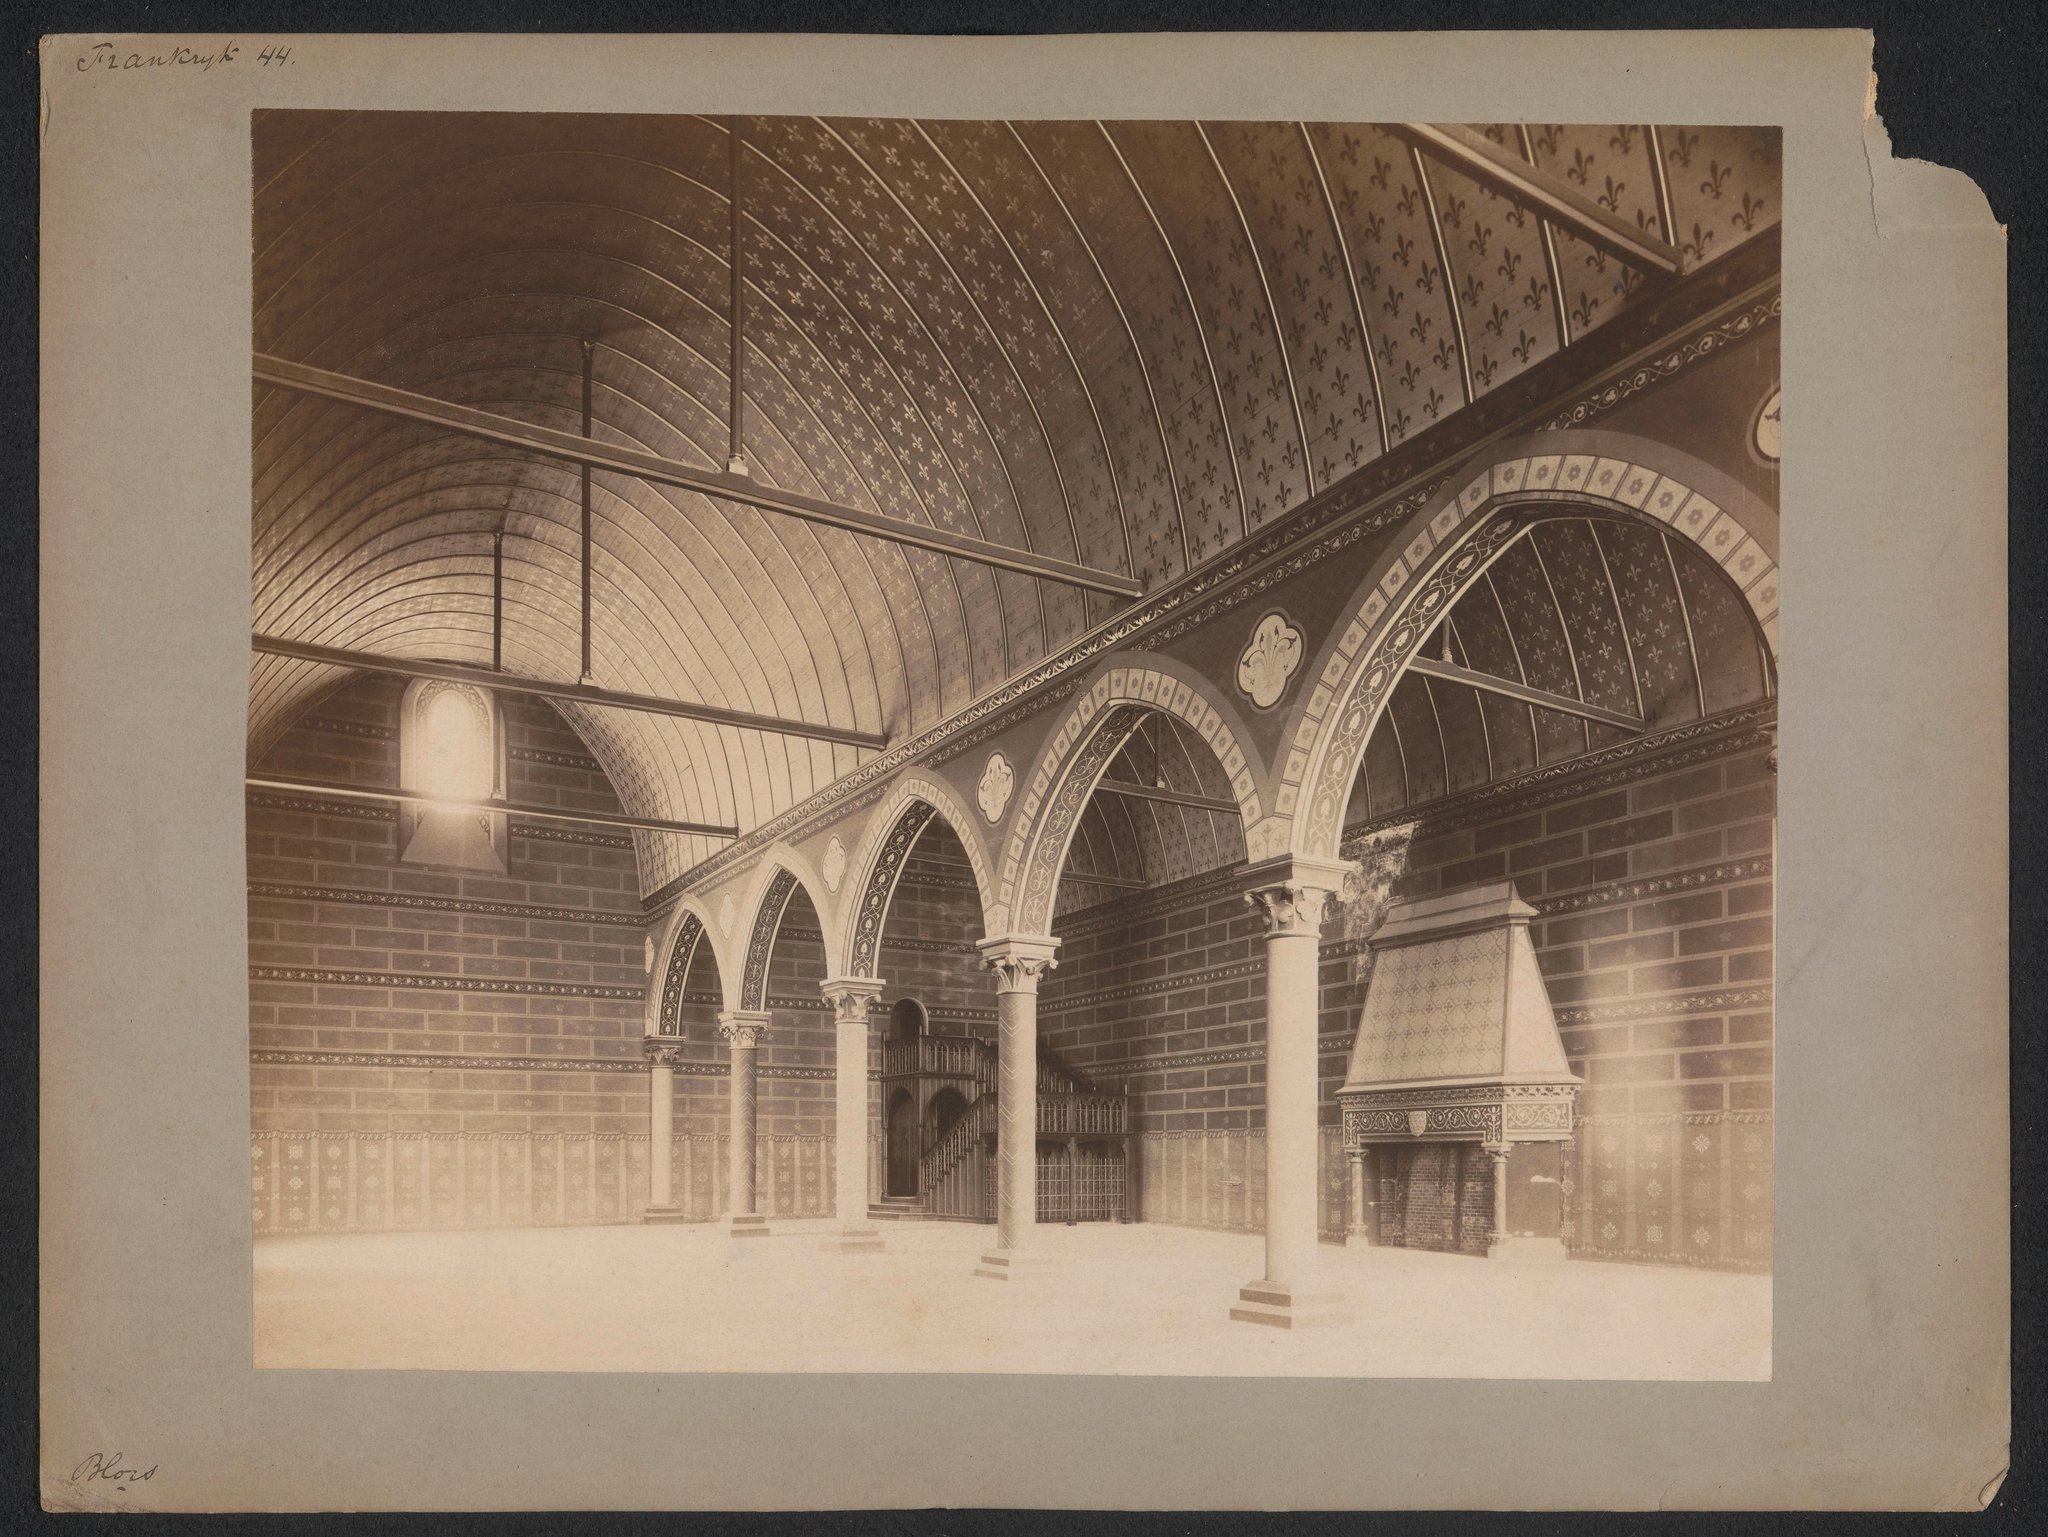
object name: photograph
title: Zaal in het Kasteel van Blois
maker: Anonymous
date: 1850-1900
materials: cardboard, photographic support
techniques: albumen print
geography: blois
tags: other rooms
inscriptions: annotation: ‘Blois’, annotation: ‘Frankrijk 44.’, collector's mark: ‘RIJKS NORMAALSCHOOL voor T[EEKENONDERWIJZERS] AMSTERDAM’, annotation: ‘Blois’